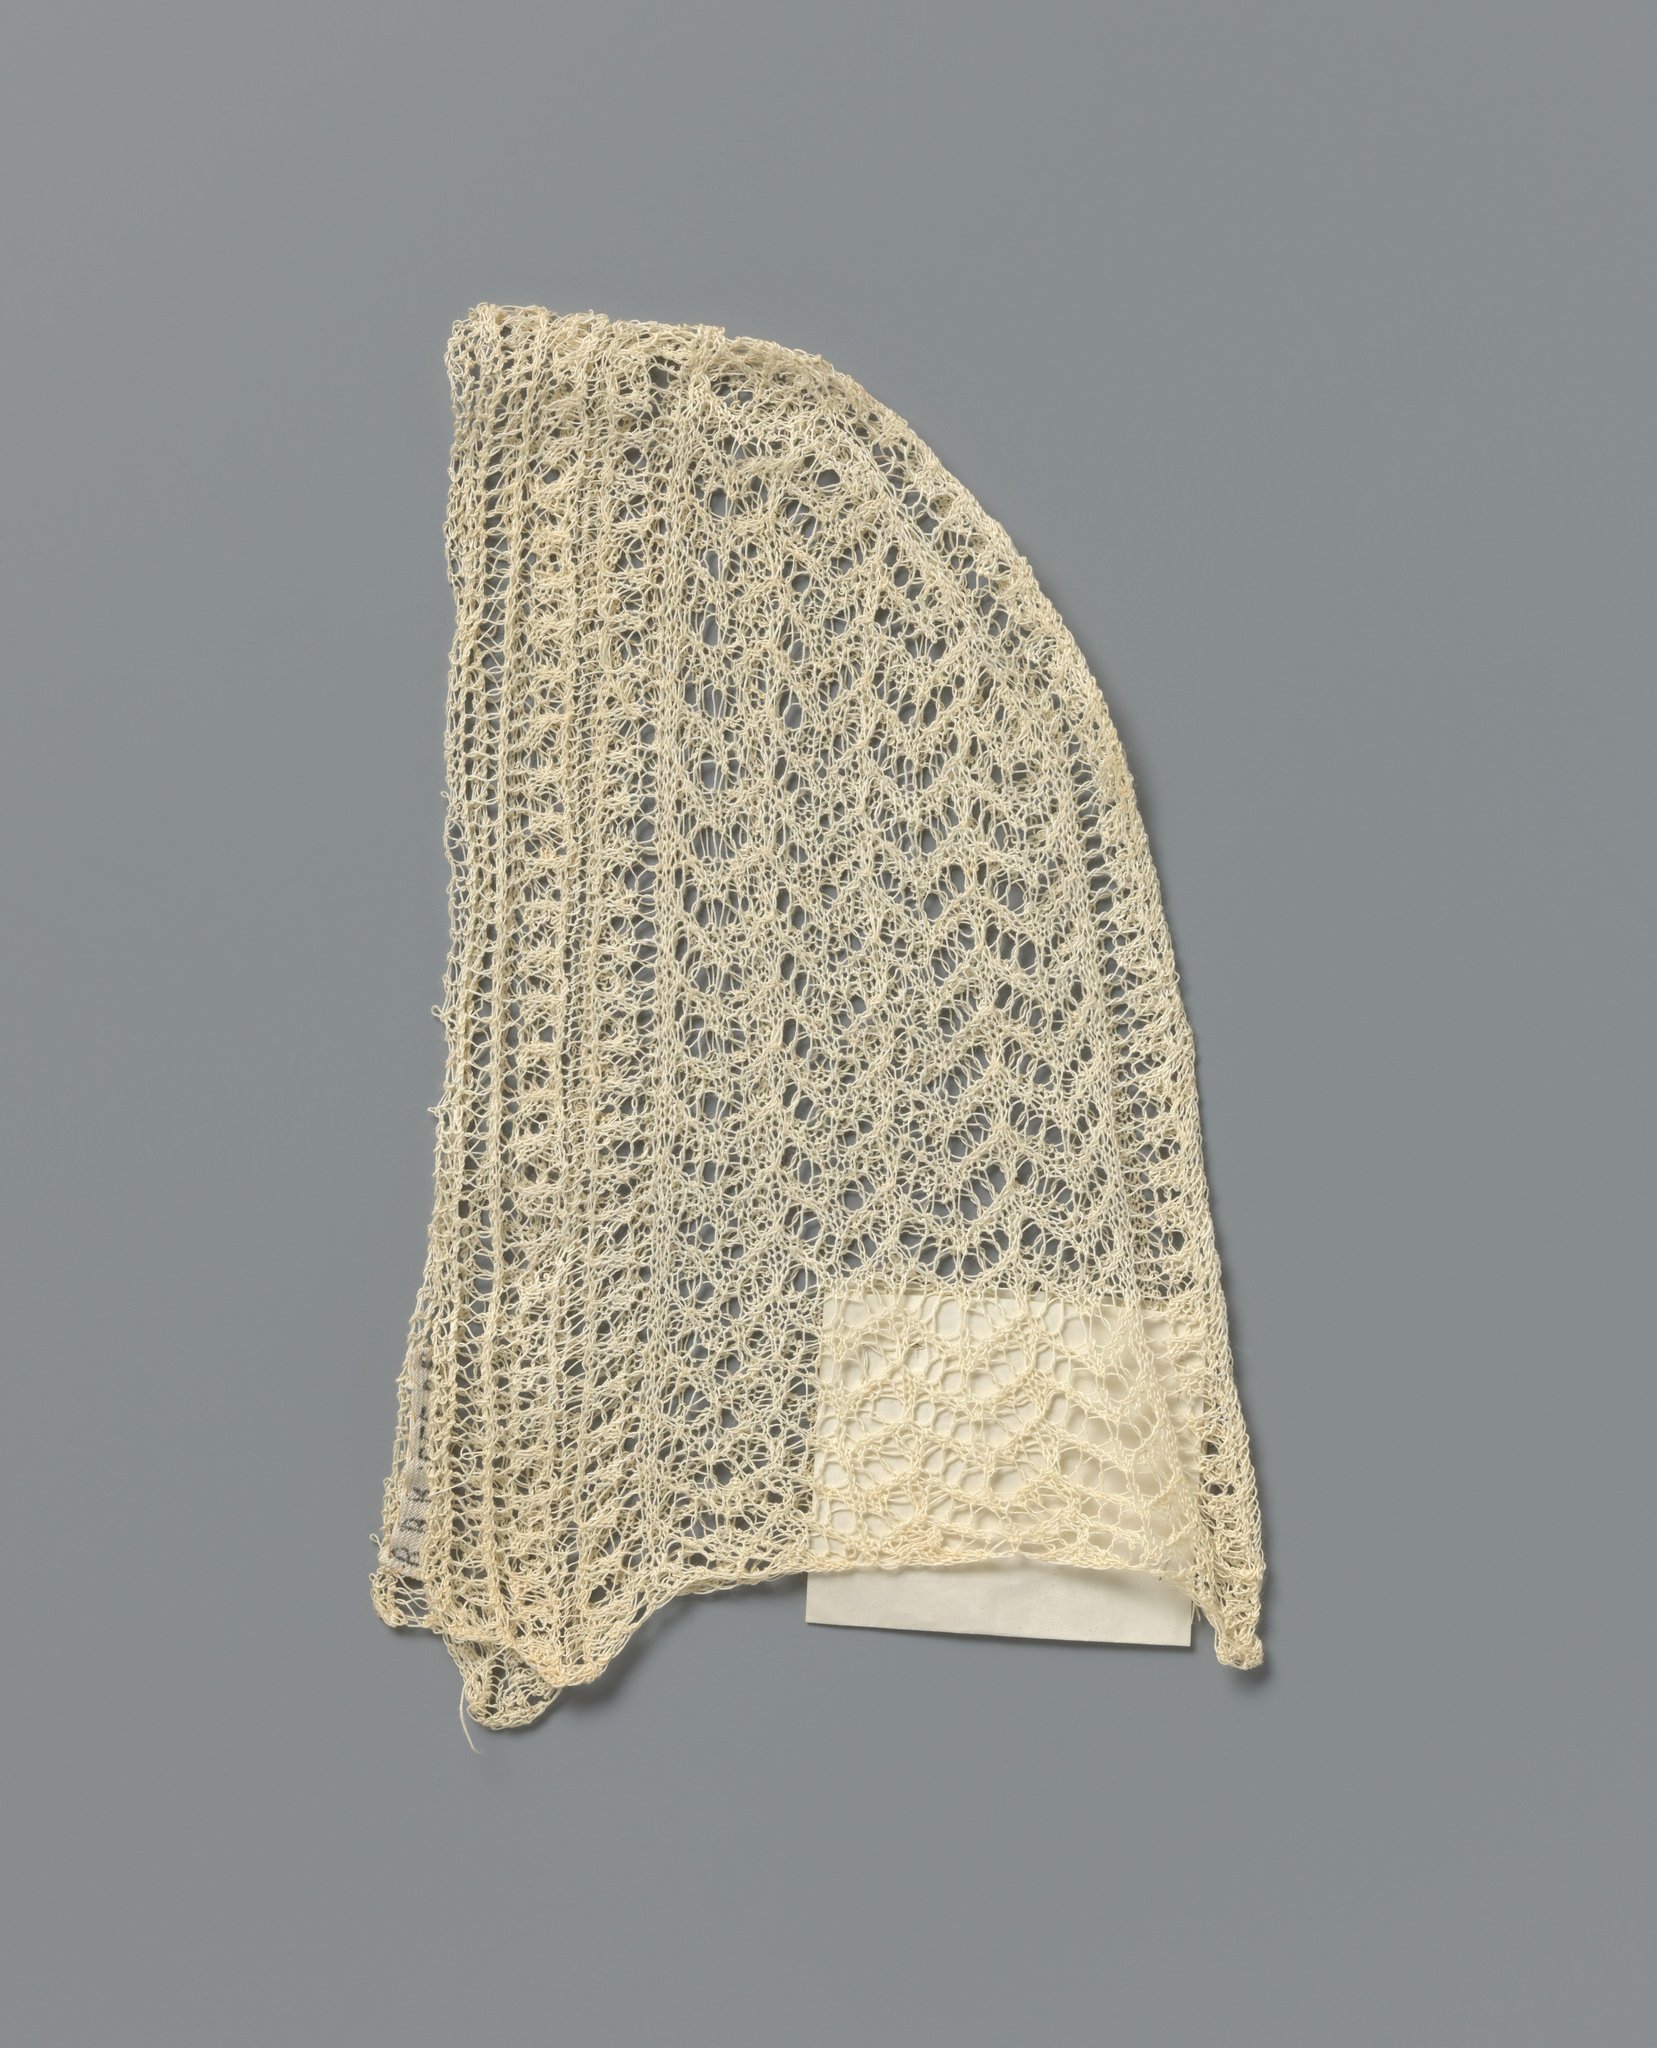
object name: hoofddeksel, hoofdbedekking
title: Gebreide ondermuts van fijne katoen, met opengewerkte steek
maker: Anonymous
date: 1900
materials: cotton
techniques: embroidery, knitting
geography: friesland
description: Ondermutsje van breiwerk van fijne katoen. De kantsteek vertoont een zigzagpatroon met omlijstingen langs voorhoofd en van middenvoor over de kruin tot middenachter.